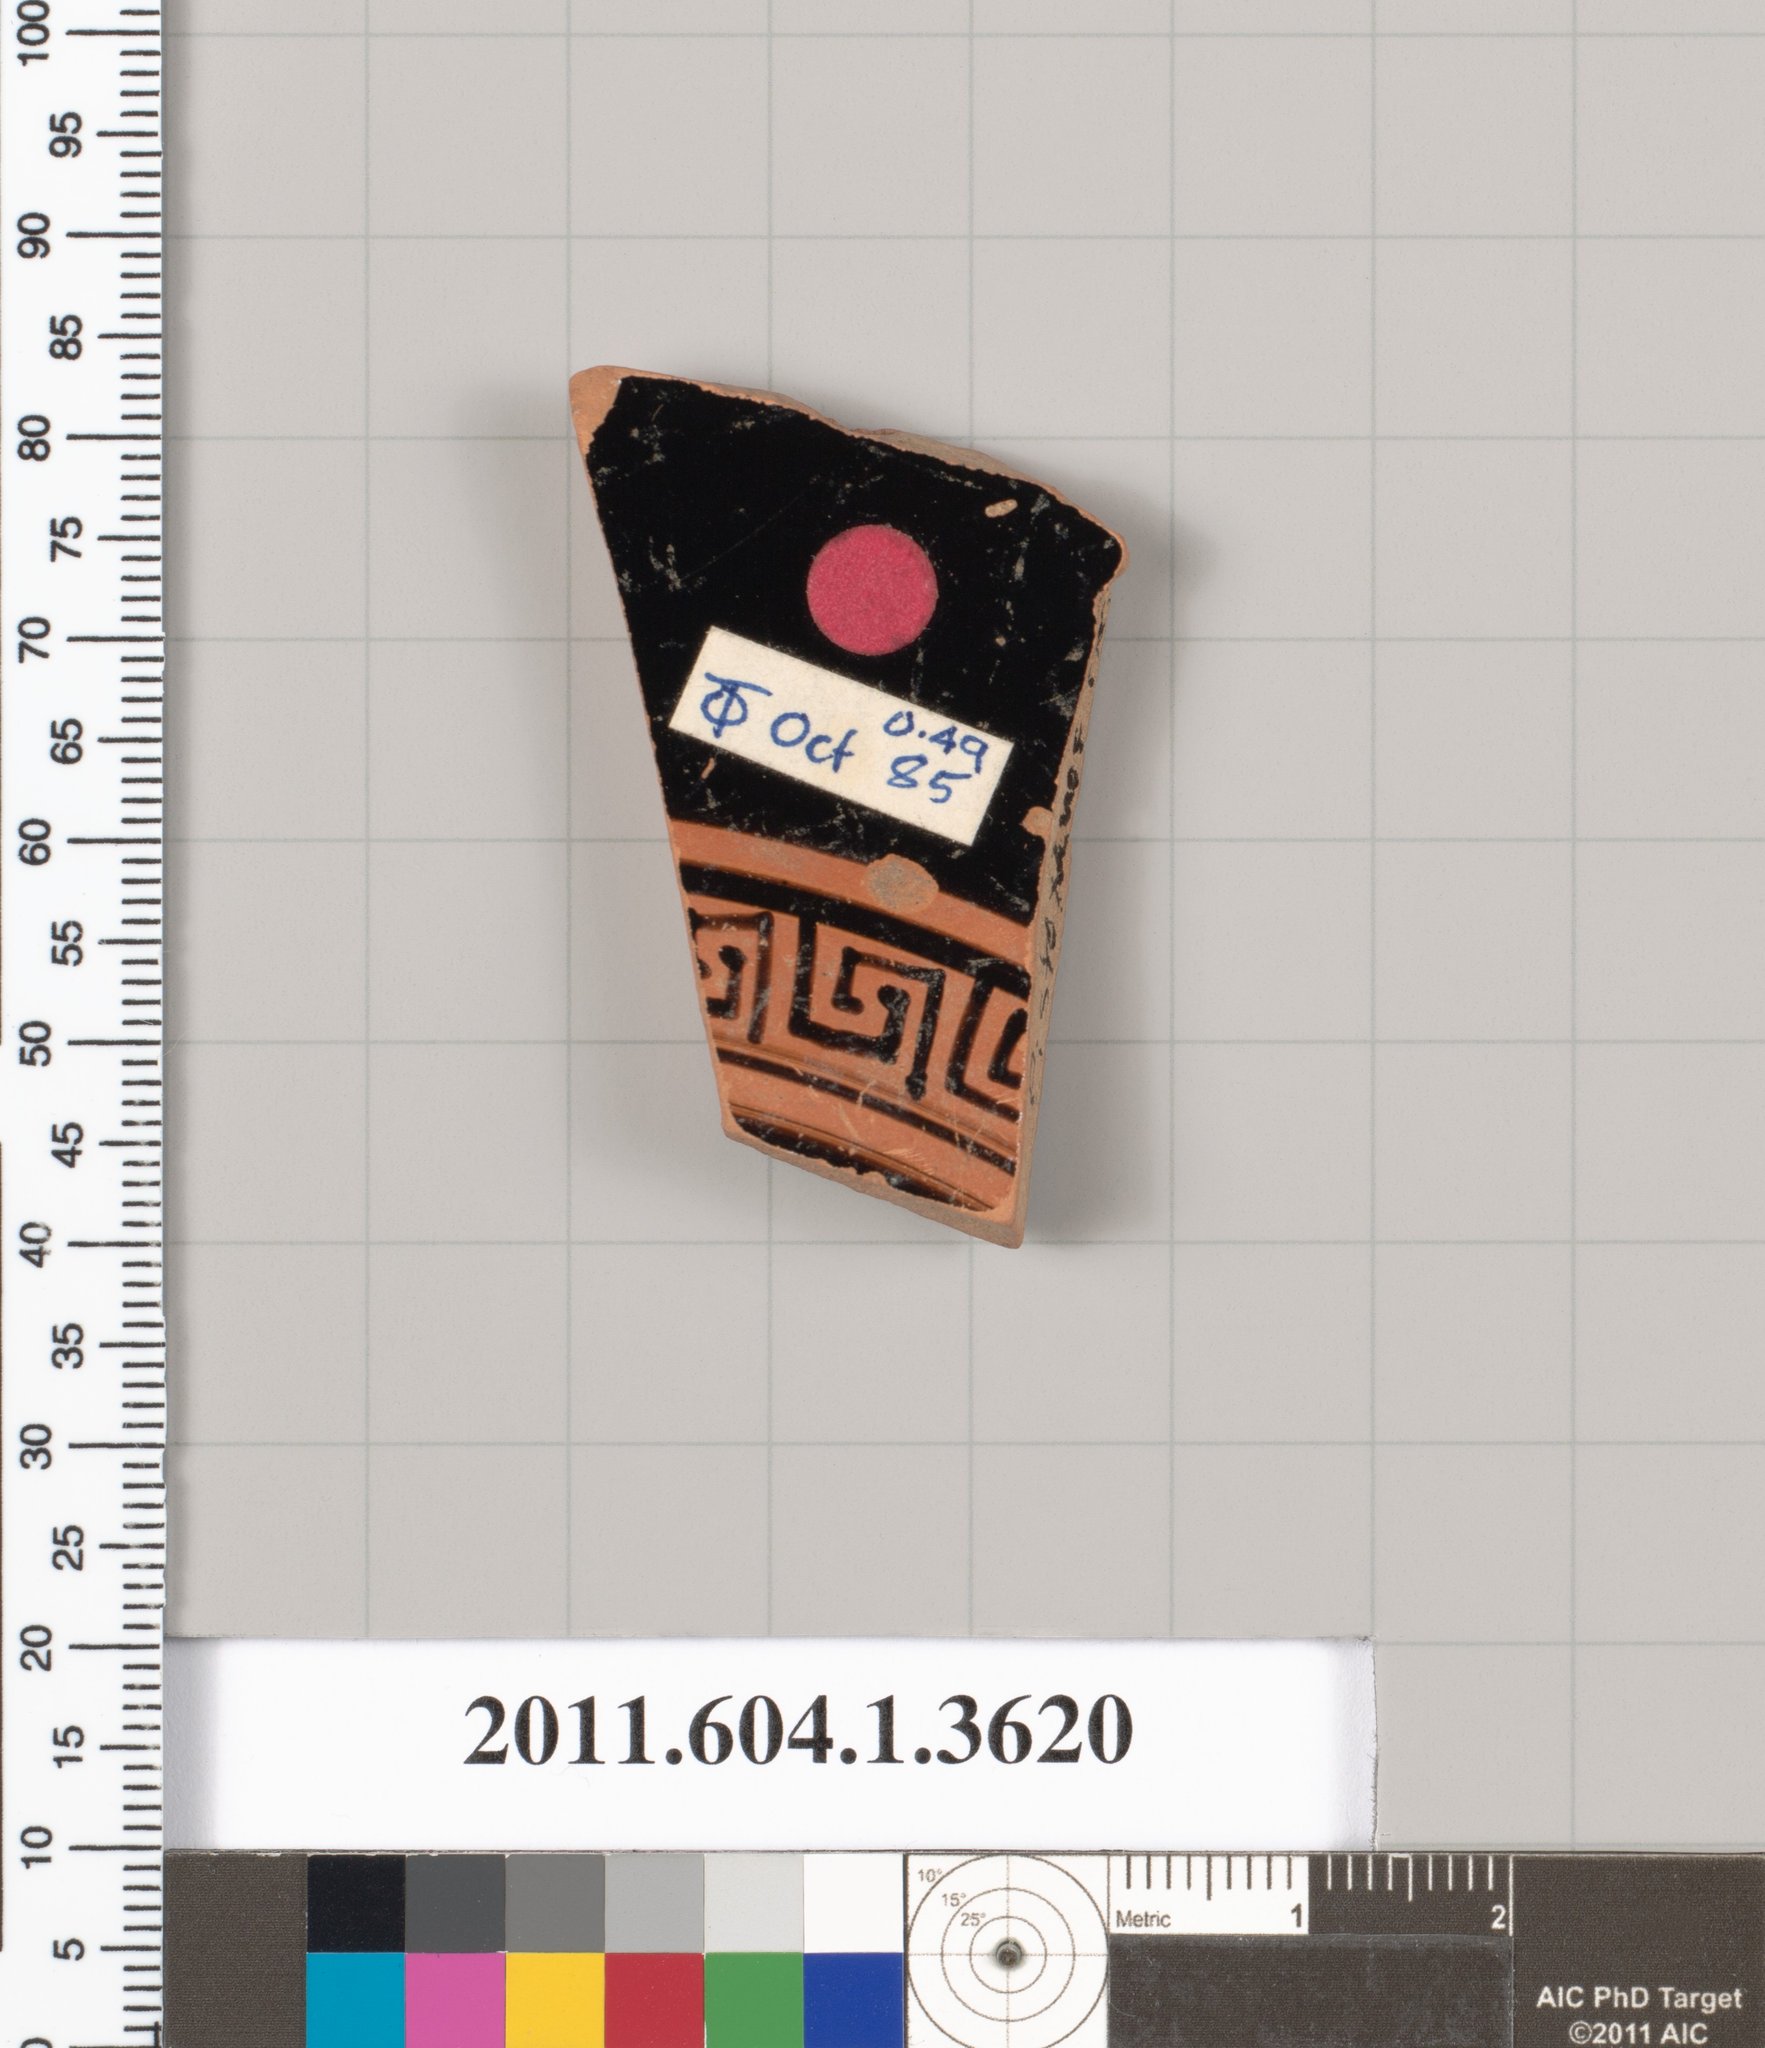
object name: kylix fragment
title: Terracotta fragment of a kylix (drinking cup)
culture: greek, attic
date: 490-470 BCE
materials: terracotta